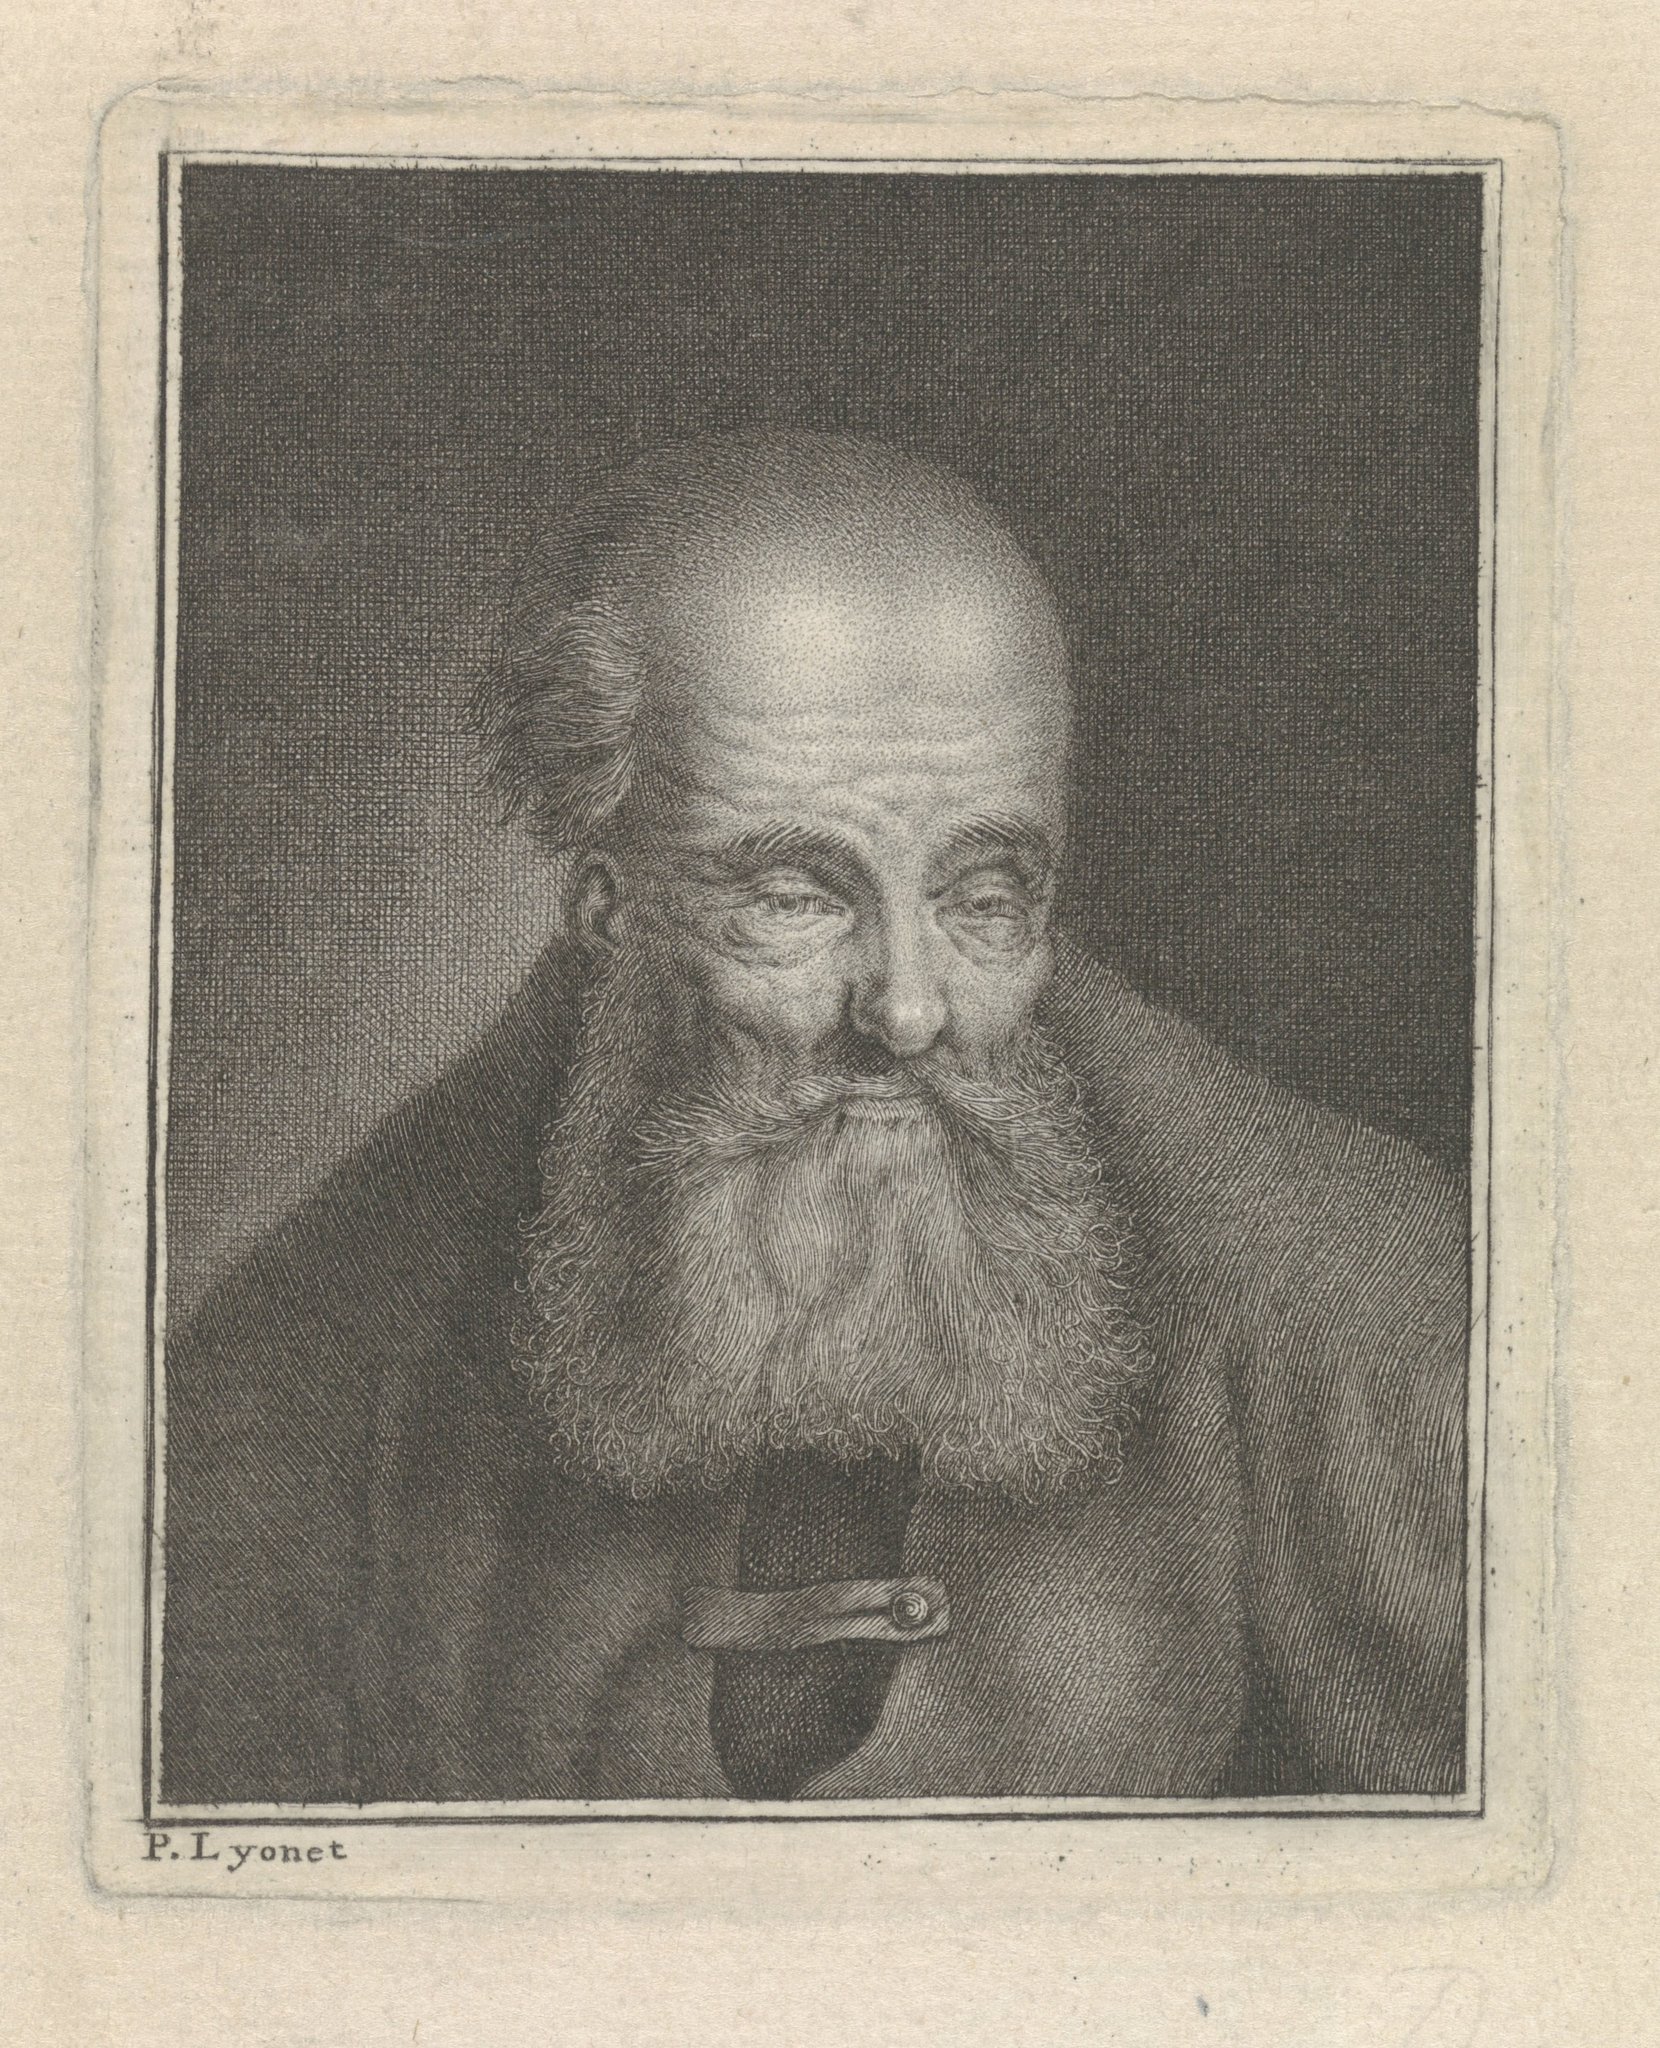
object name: print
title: Oude man met baard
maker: pieter lyonet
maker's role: draughtsman, print maker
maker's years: 1706-1789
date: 1716-1789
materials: paper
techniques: engraving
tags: old man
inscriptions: collector's mark: Lugt 2228